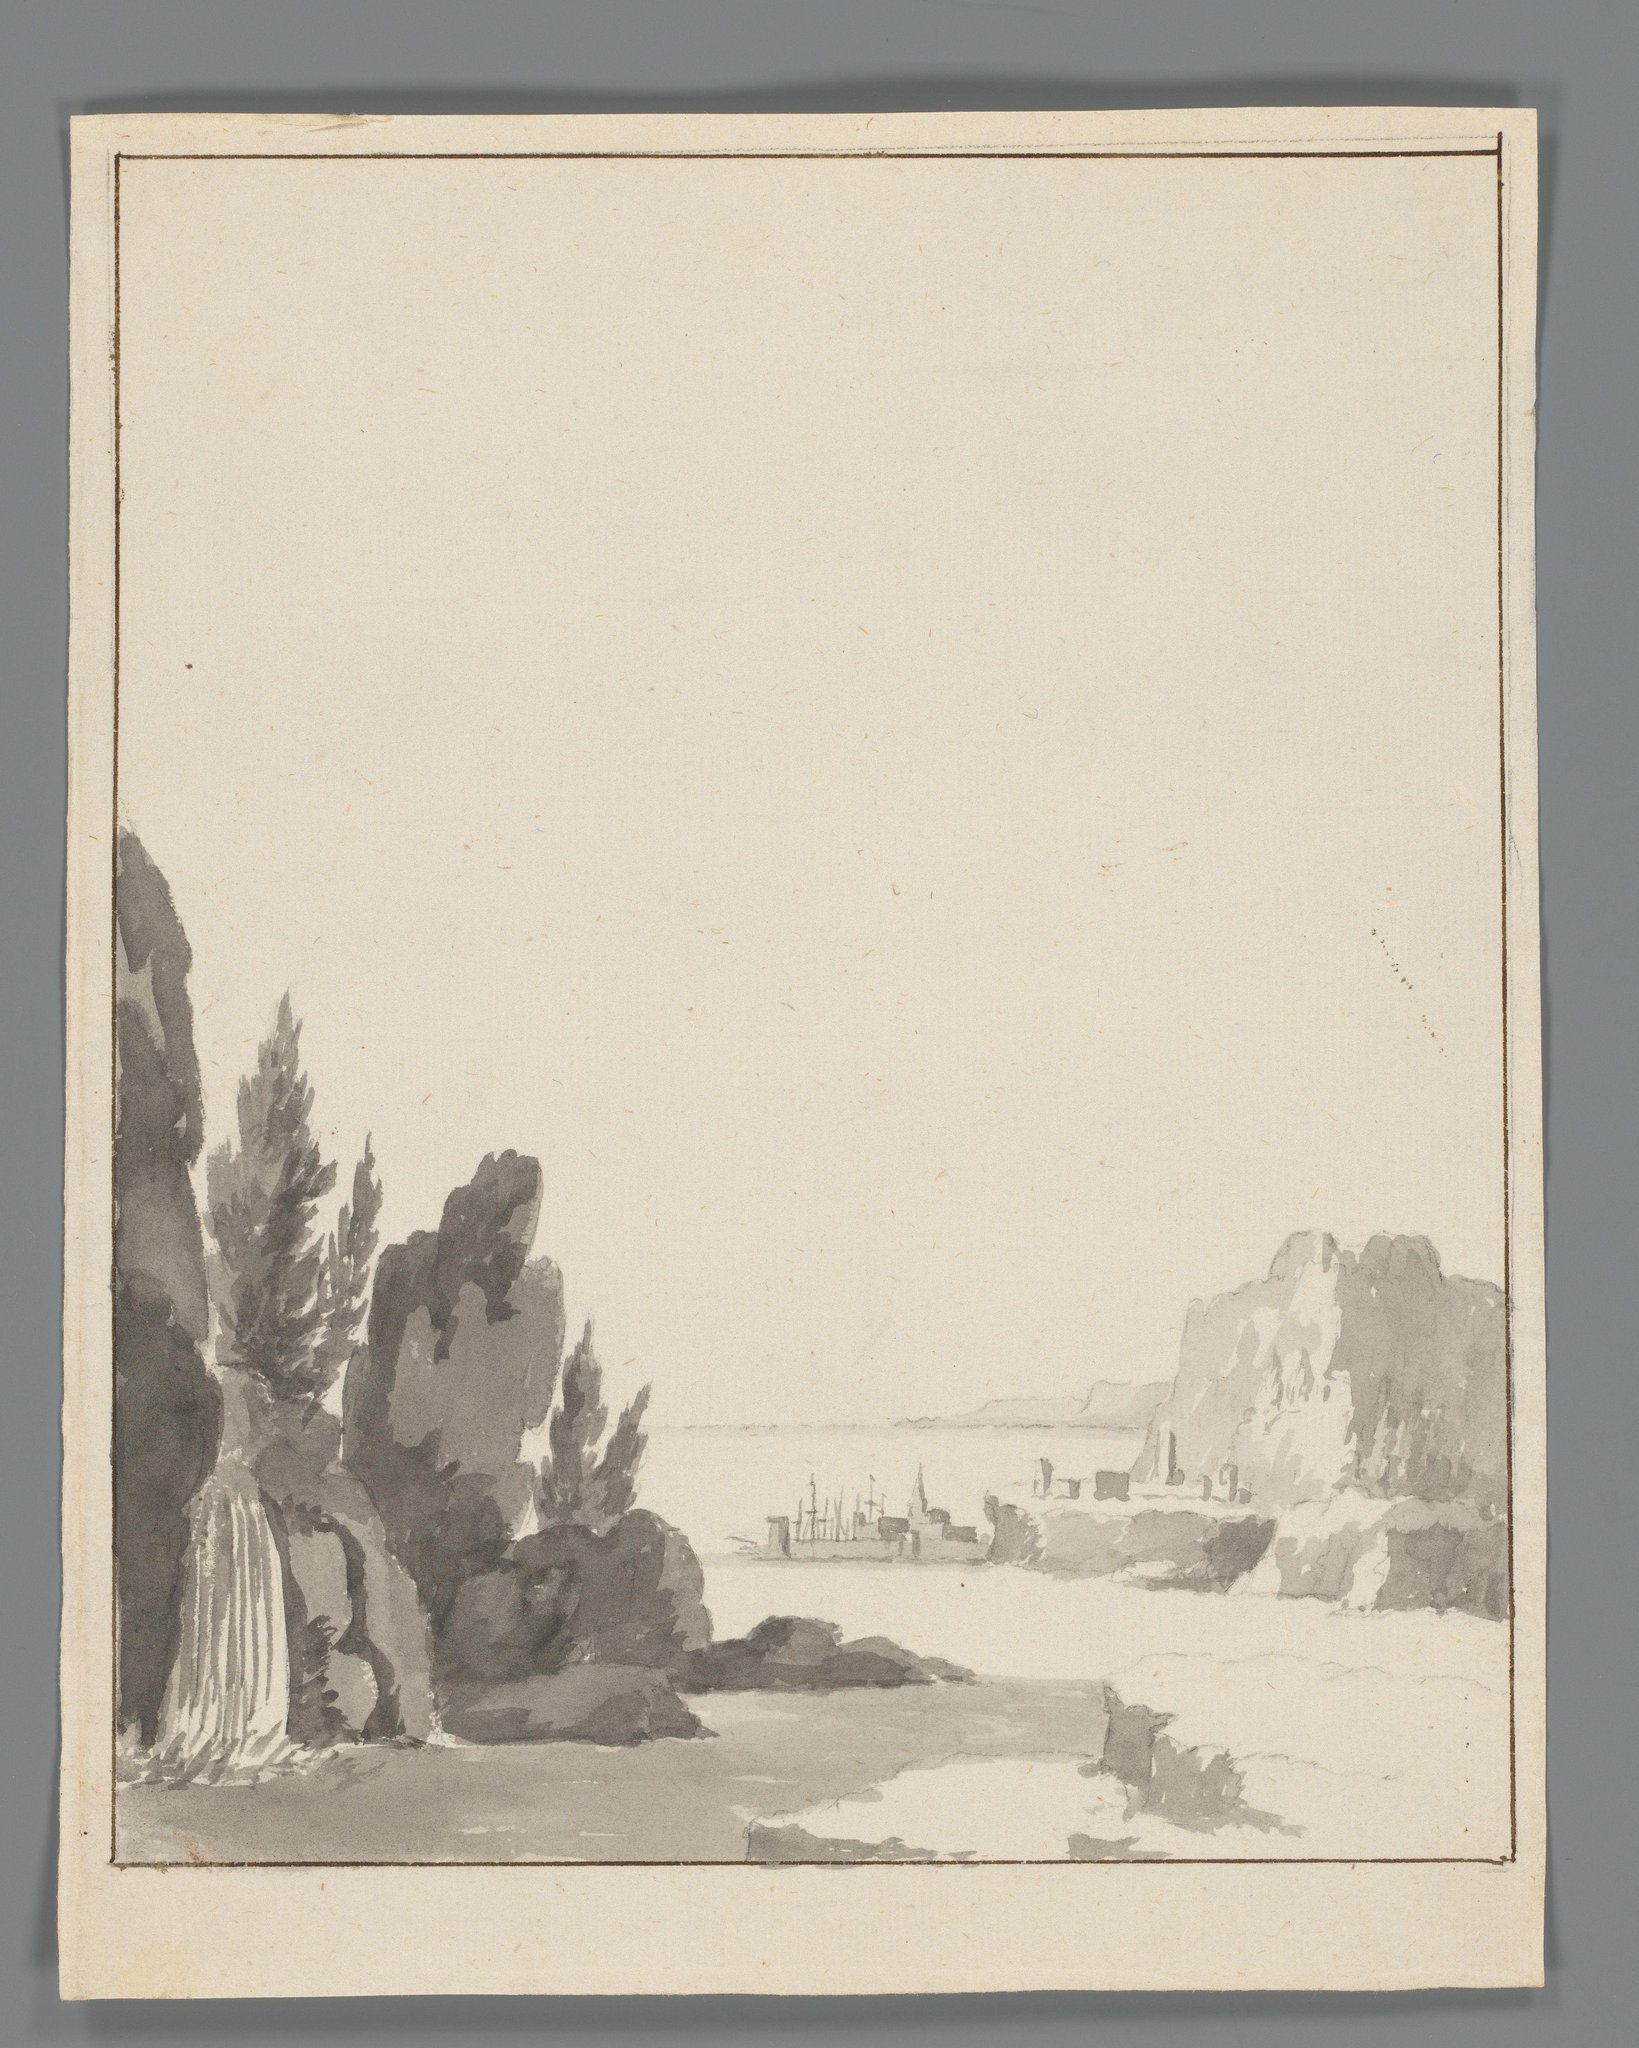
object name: drawing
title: Gezicht op een stad aan het water met op de voorgrond een waterval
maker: matthijs balen (1684-1766)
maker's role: draughtsman, painter, print maker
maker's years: 1684-1766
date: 1694-1766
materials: paper, pencil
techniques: brush, pen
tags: city-view, and landscape with man-made constructions, waterfall